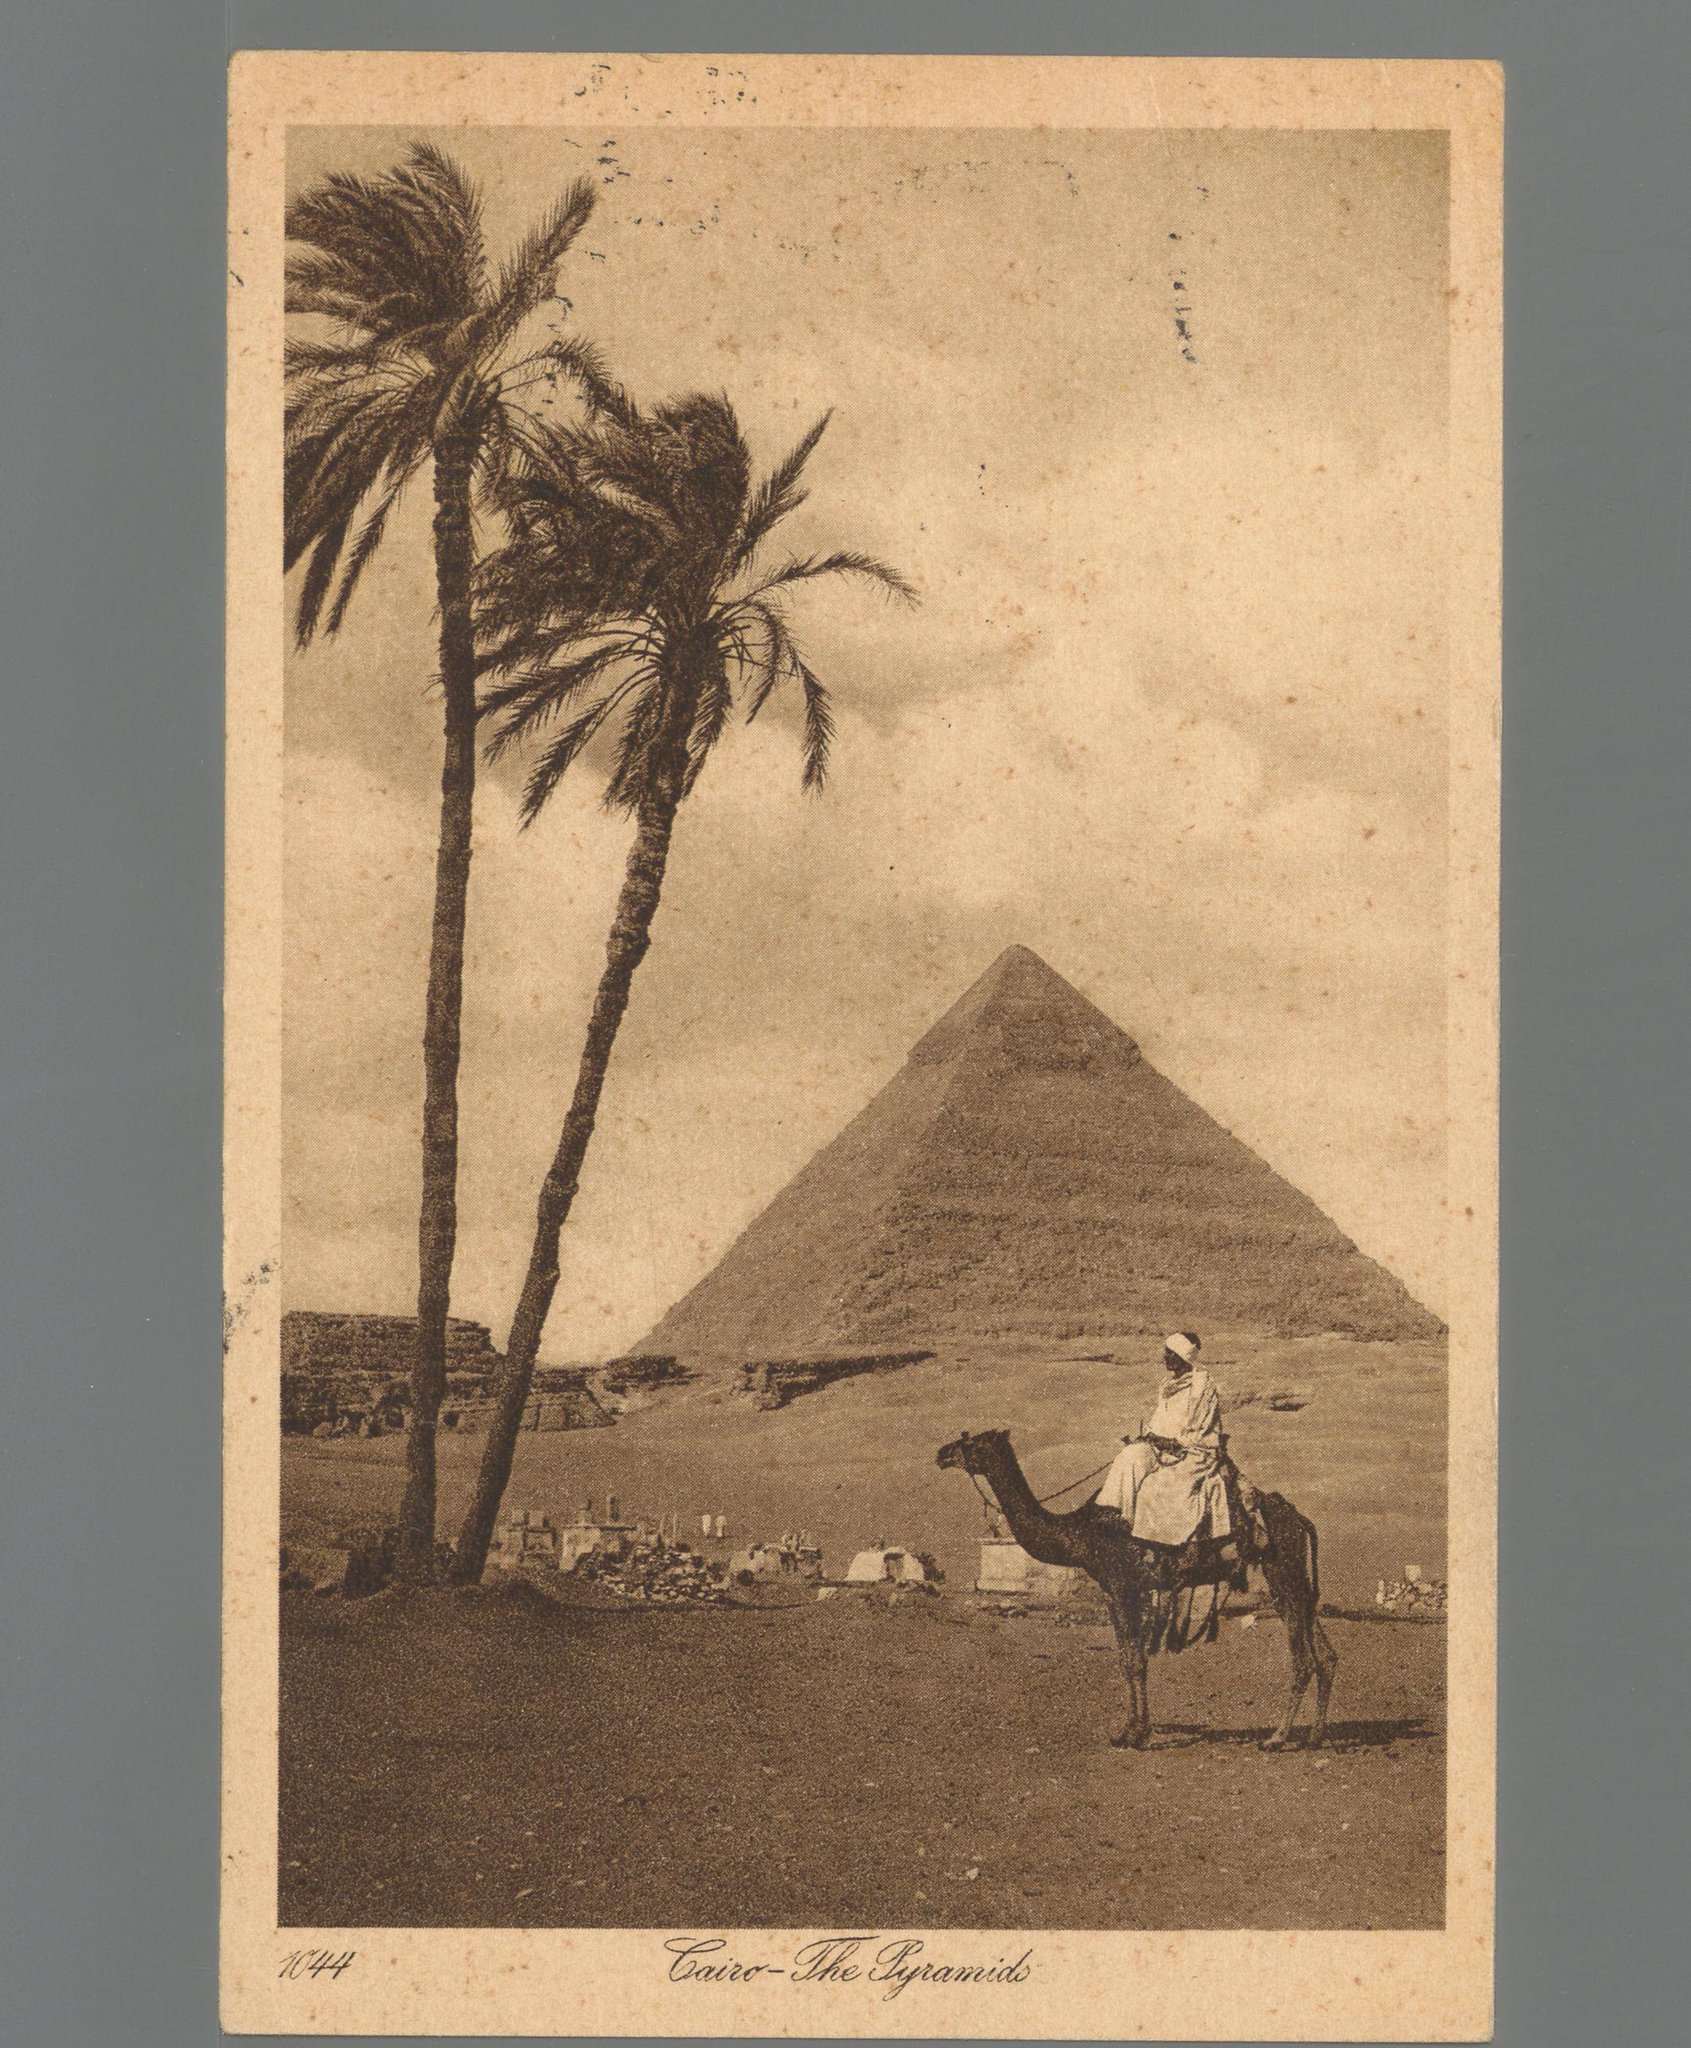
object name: ansichtkaart, prentbriefkaart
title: Cairo - The Pyramids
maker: Anonymous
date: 1907-1925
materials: cardboard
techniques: rotogravure, writing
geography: cairo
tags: quadrangular pyramid, desert, trees: palm-tree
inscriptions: postage stamp